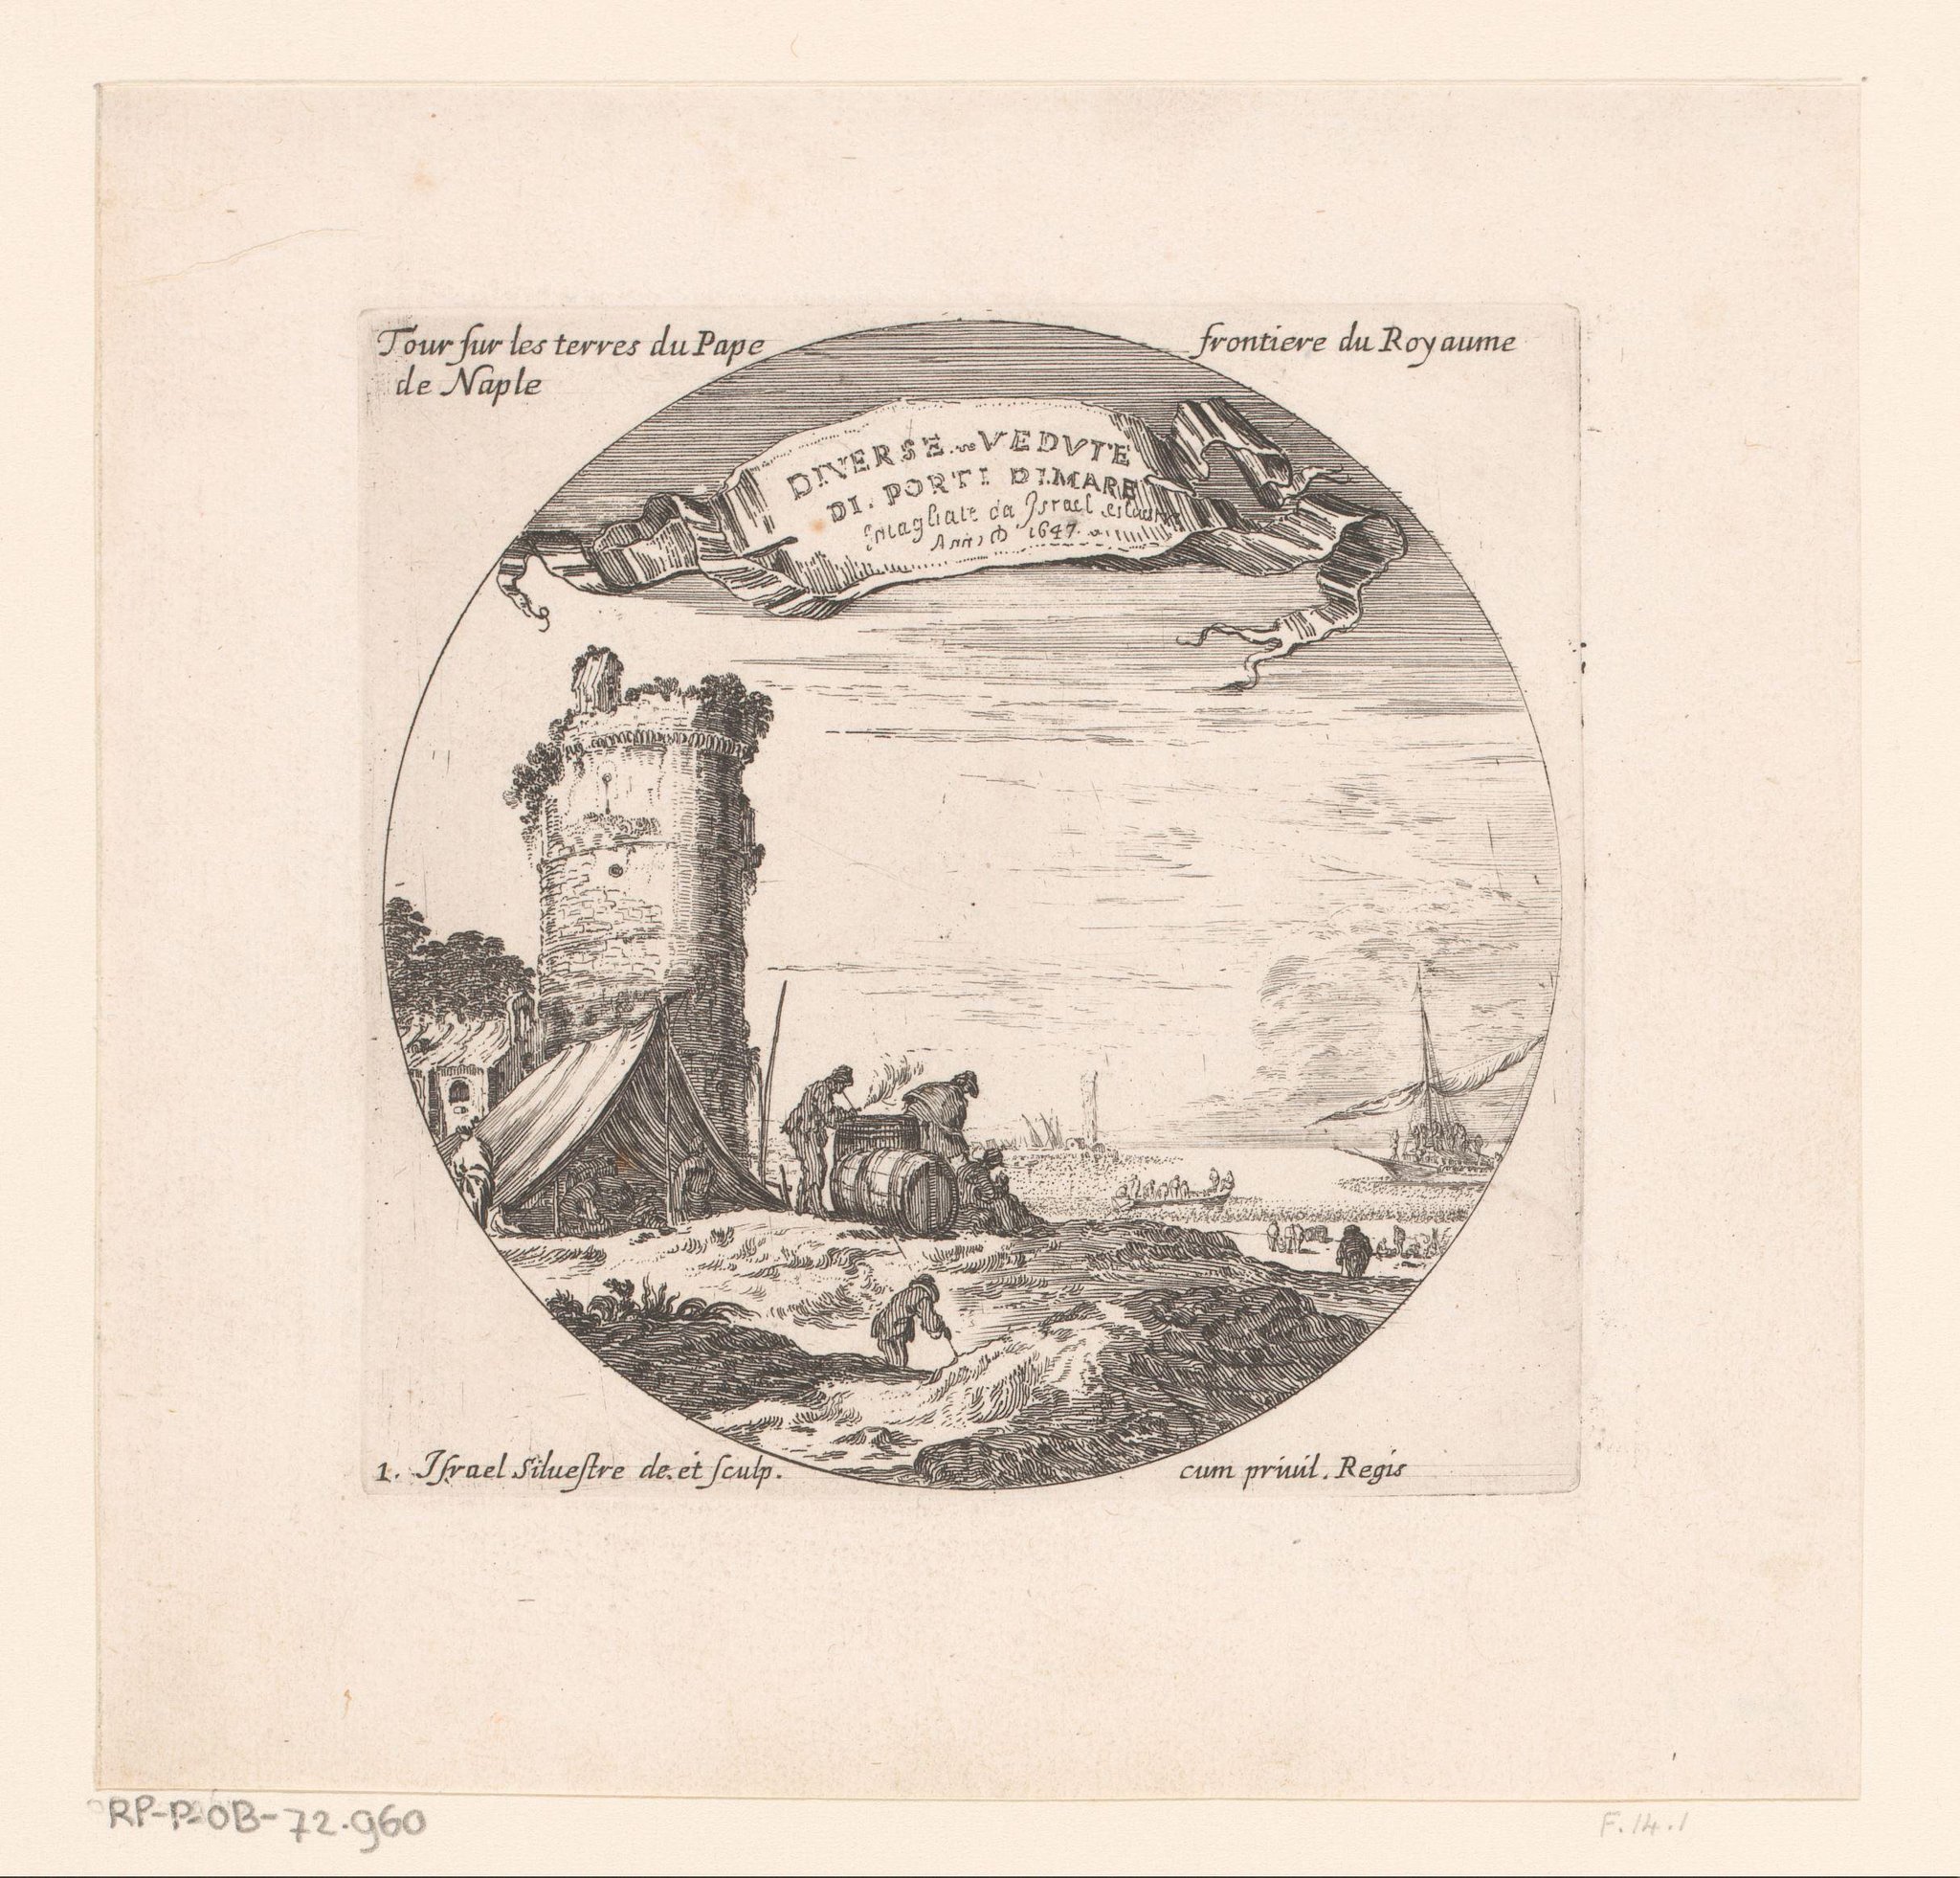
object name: titelprent, frontispice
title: Diverse Vedute di Porti di Mare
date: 1647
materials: paper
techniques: etching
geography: france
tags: landscape with tower or castle, naples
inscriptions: collector's mark: Lugt 240